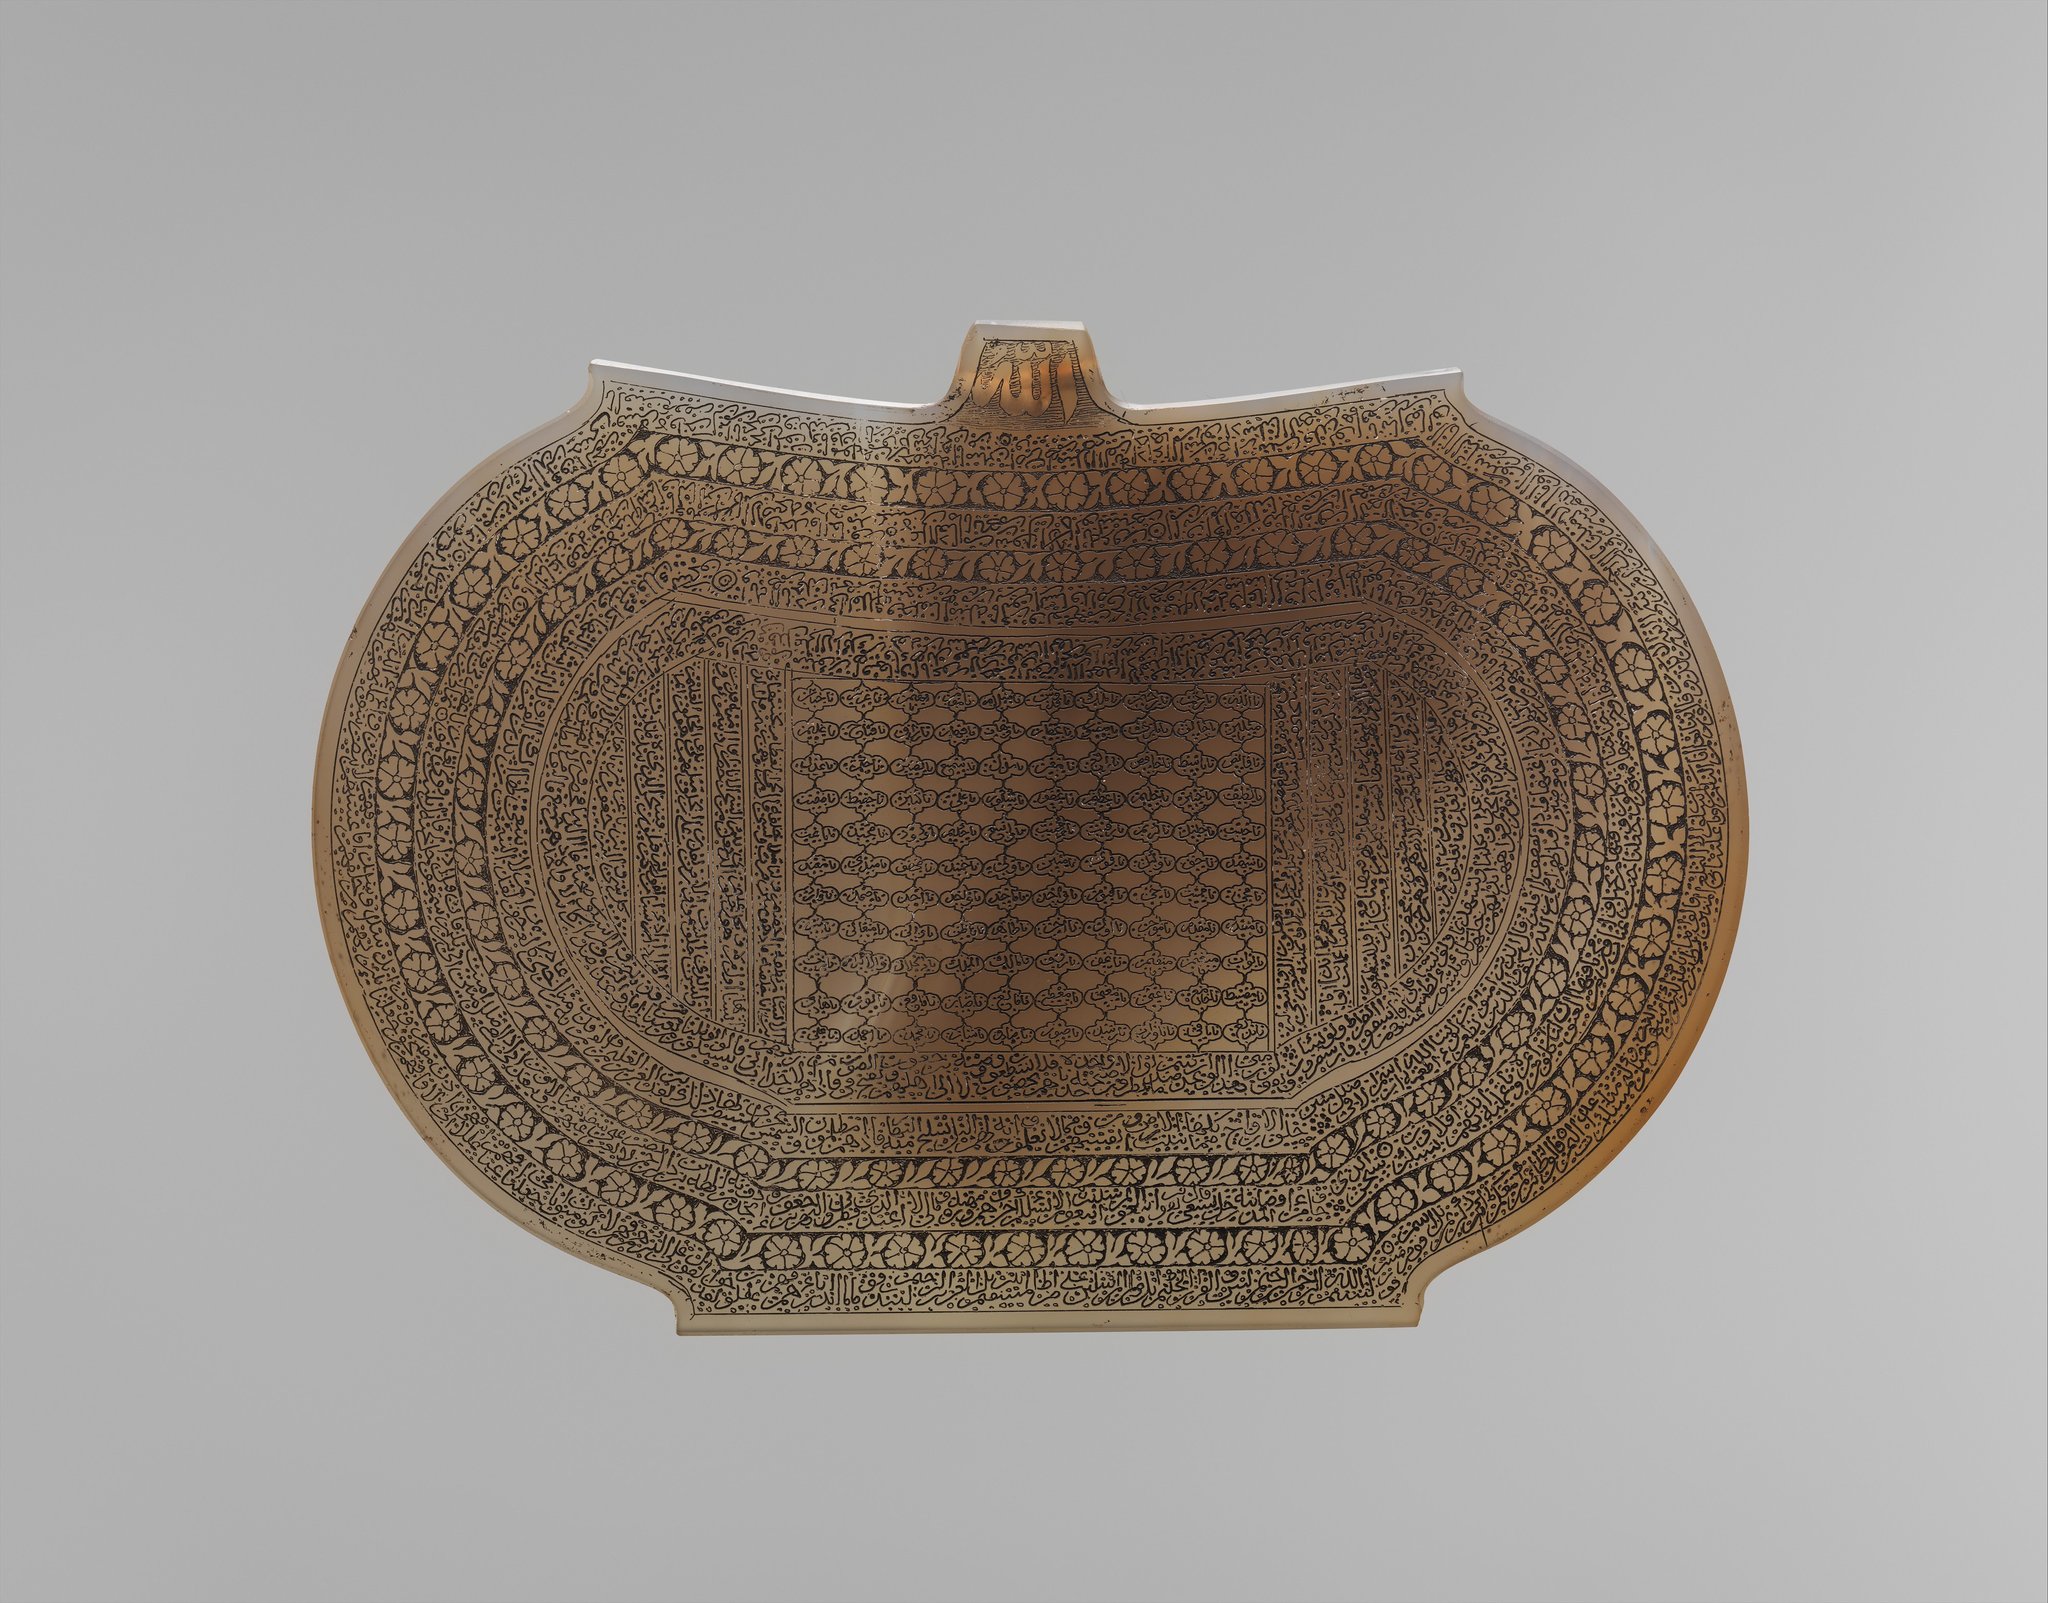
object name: necklace, bead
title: Agate Amulet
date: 1734-1766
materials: stone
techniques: inlay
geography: iran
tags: amulets,flowers